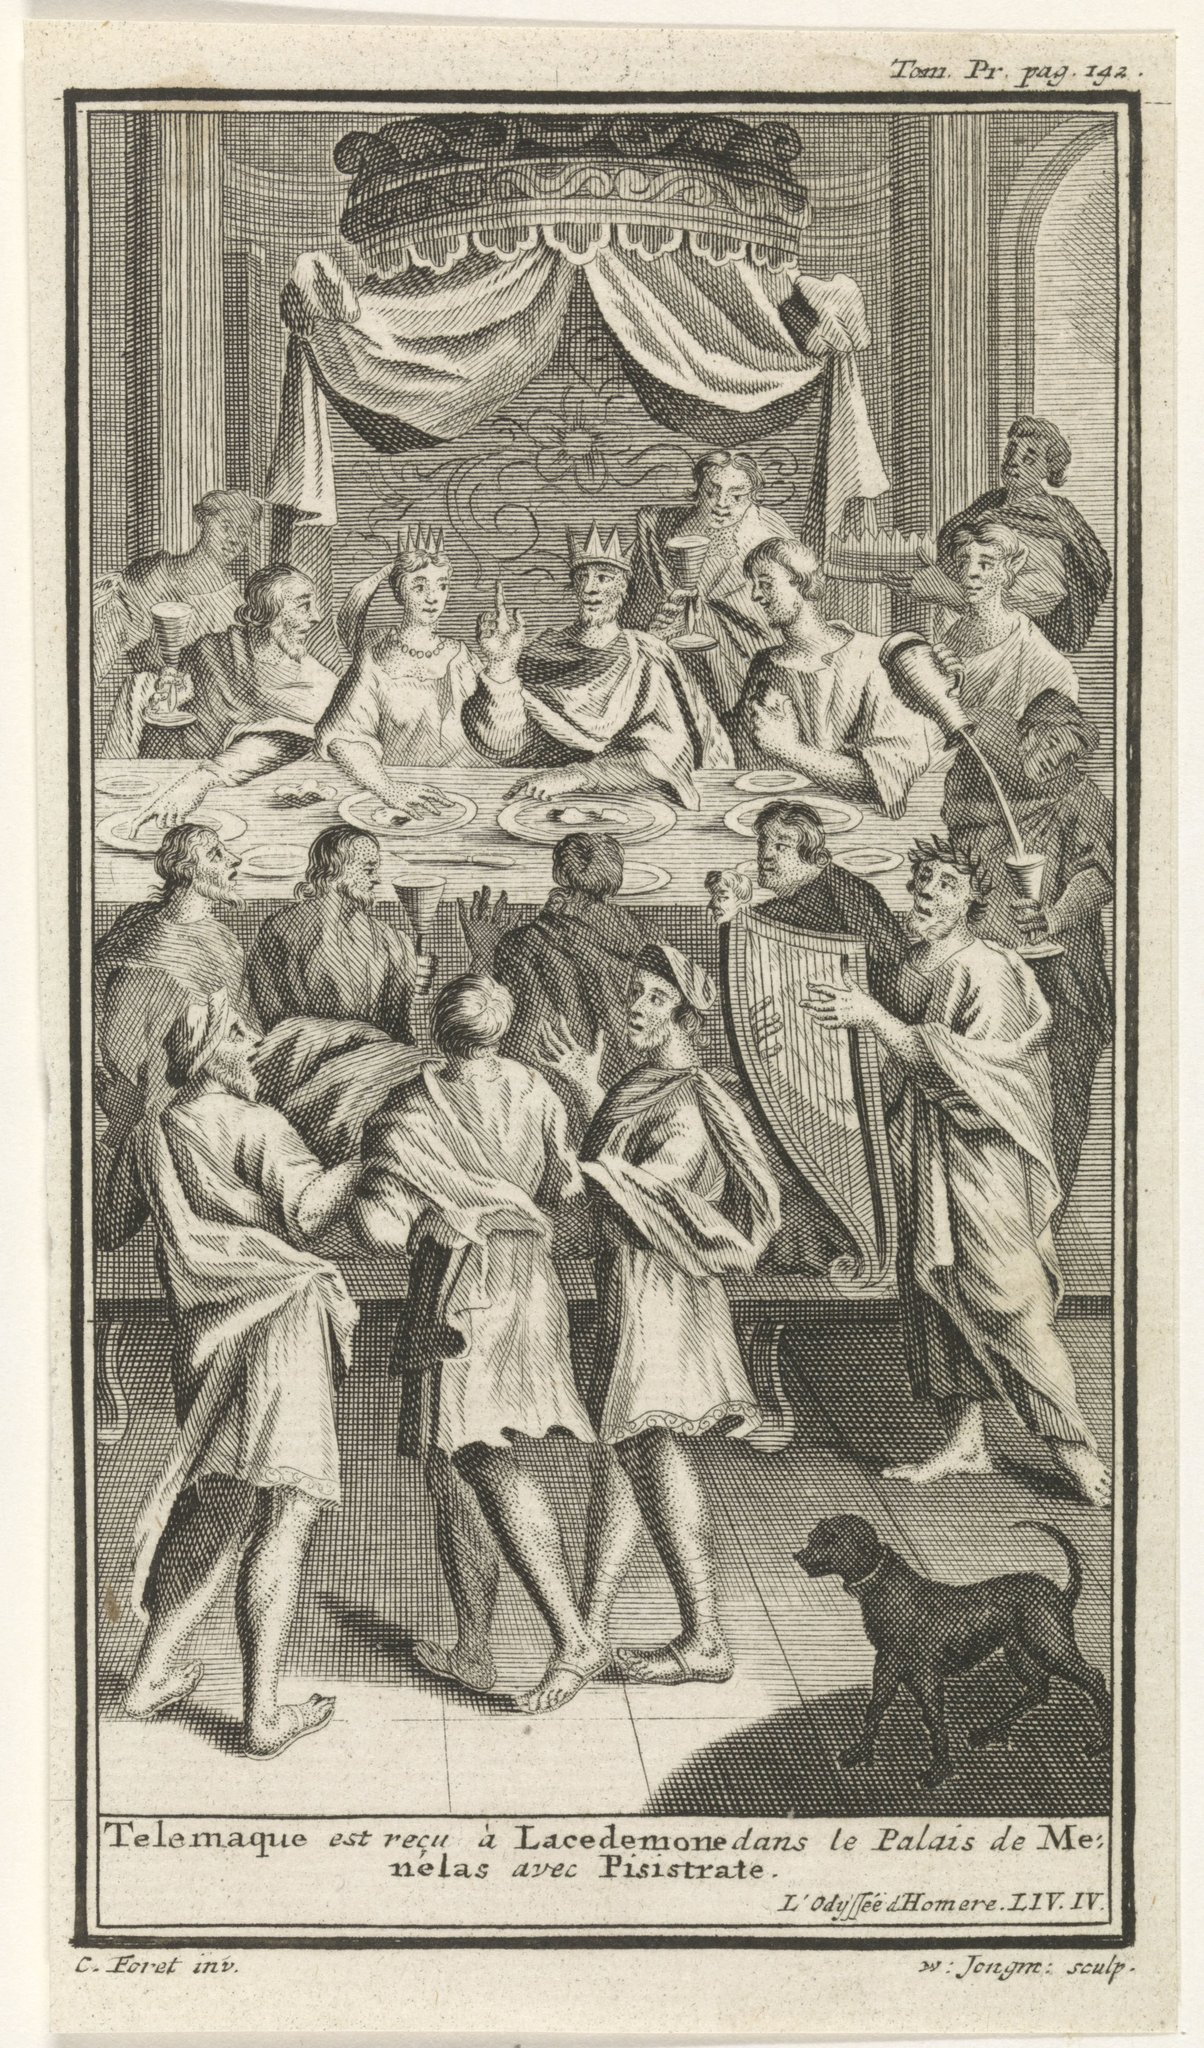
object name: book illustration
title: Telemaque est re à Lacedemone (...)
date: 1712-1744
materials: paper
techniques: engraving, etching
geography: amsterdam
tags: telemachus and pisistratus, son of nestor, in sparta with menelaus and helen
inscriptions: collector's mark: Lugt 2228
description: Telemachus (zoon van Odysseus) en Peisistratos (zoon van Nestor) bezoeken Helena en Menelaos in Sparta. Helena en Menelaos zitten aan een tafel, vergezeld door hovelingen. Rechts op de voorgrond een hond. Afbeelding bij het vierde deel van Homerus' Odyssee.